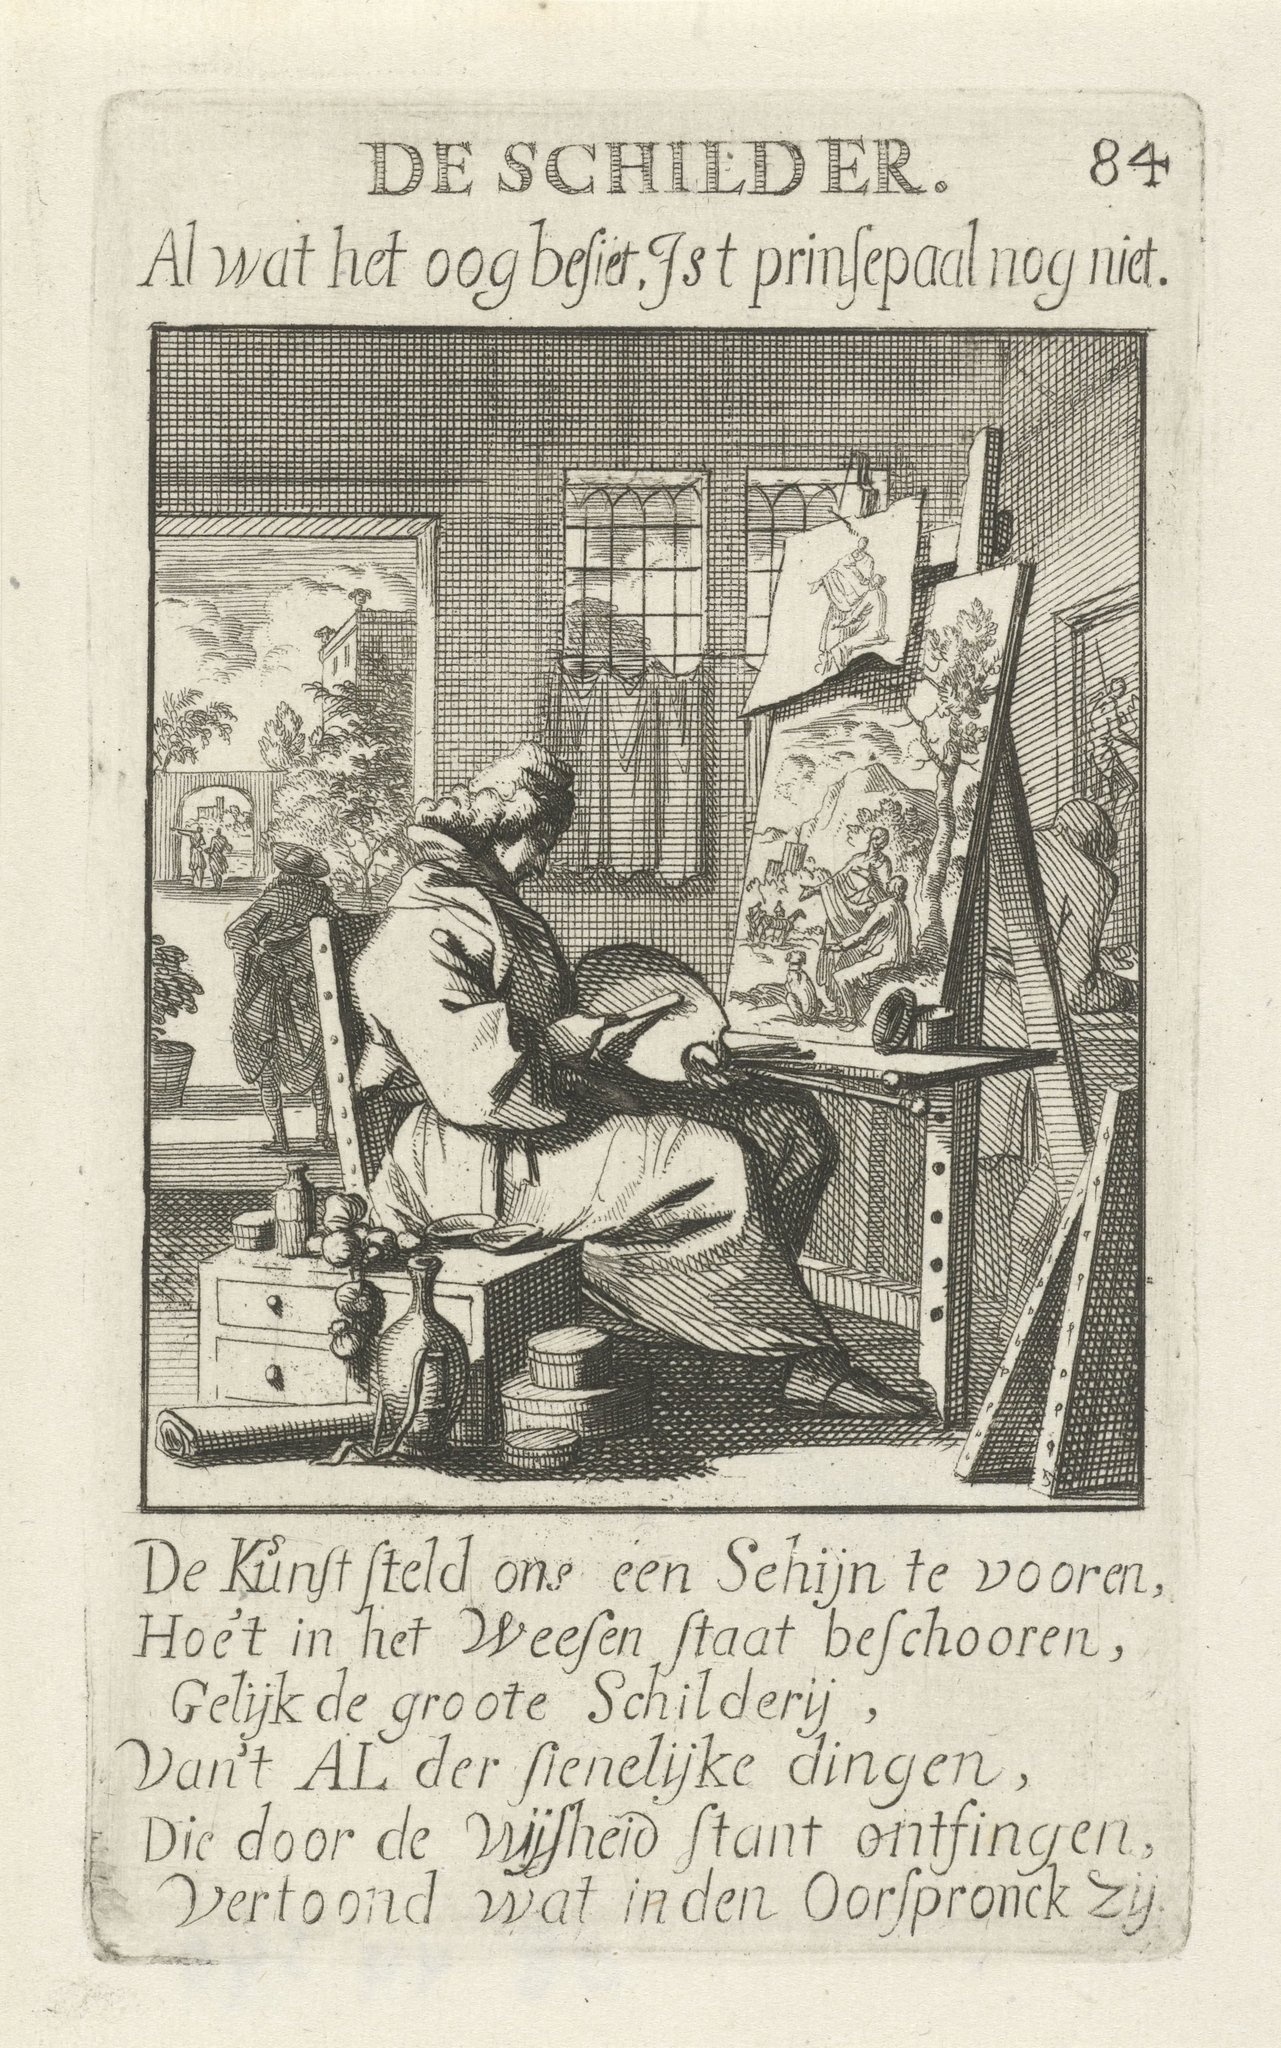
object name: print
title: De Schilder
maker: jan luyken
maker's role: draughtsman, print maker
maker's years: 1649-1712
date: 1694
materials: paper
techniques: etching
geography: amsterdam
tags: handicrafts, craftsman at work, working situations ~ painter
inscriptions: collector's mark: Lugt 2228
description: Maakt deel uit van de 100-delige serie beroepsprenten van Jan en Caspar Luyken, getiteld: Het menselyk bedryf. S.l.s.n., 1694 (eerste druk).